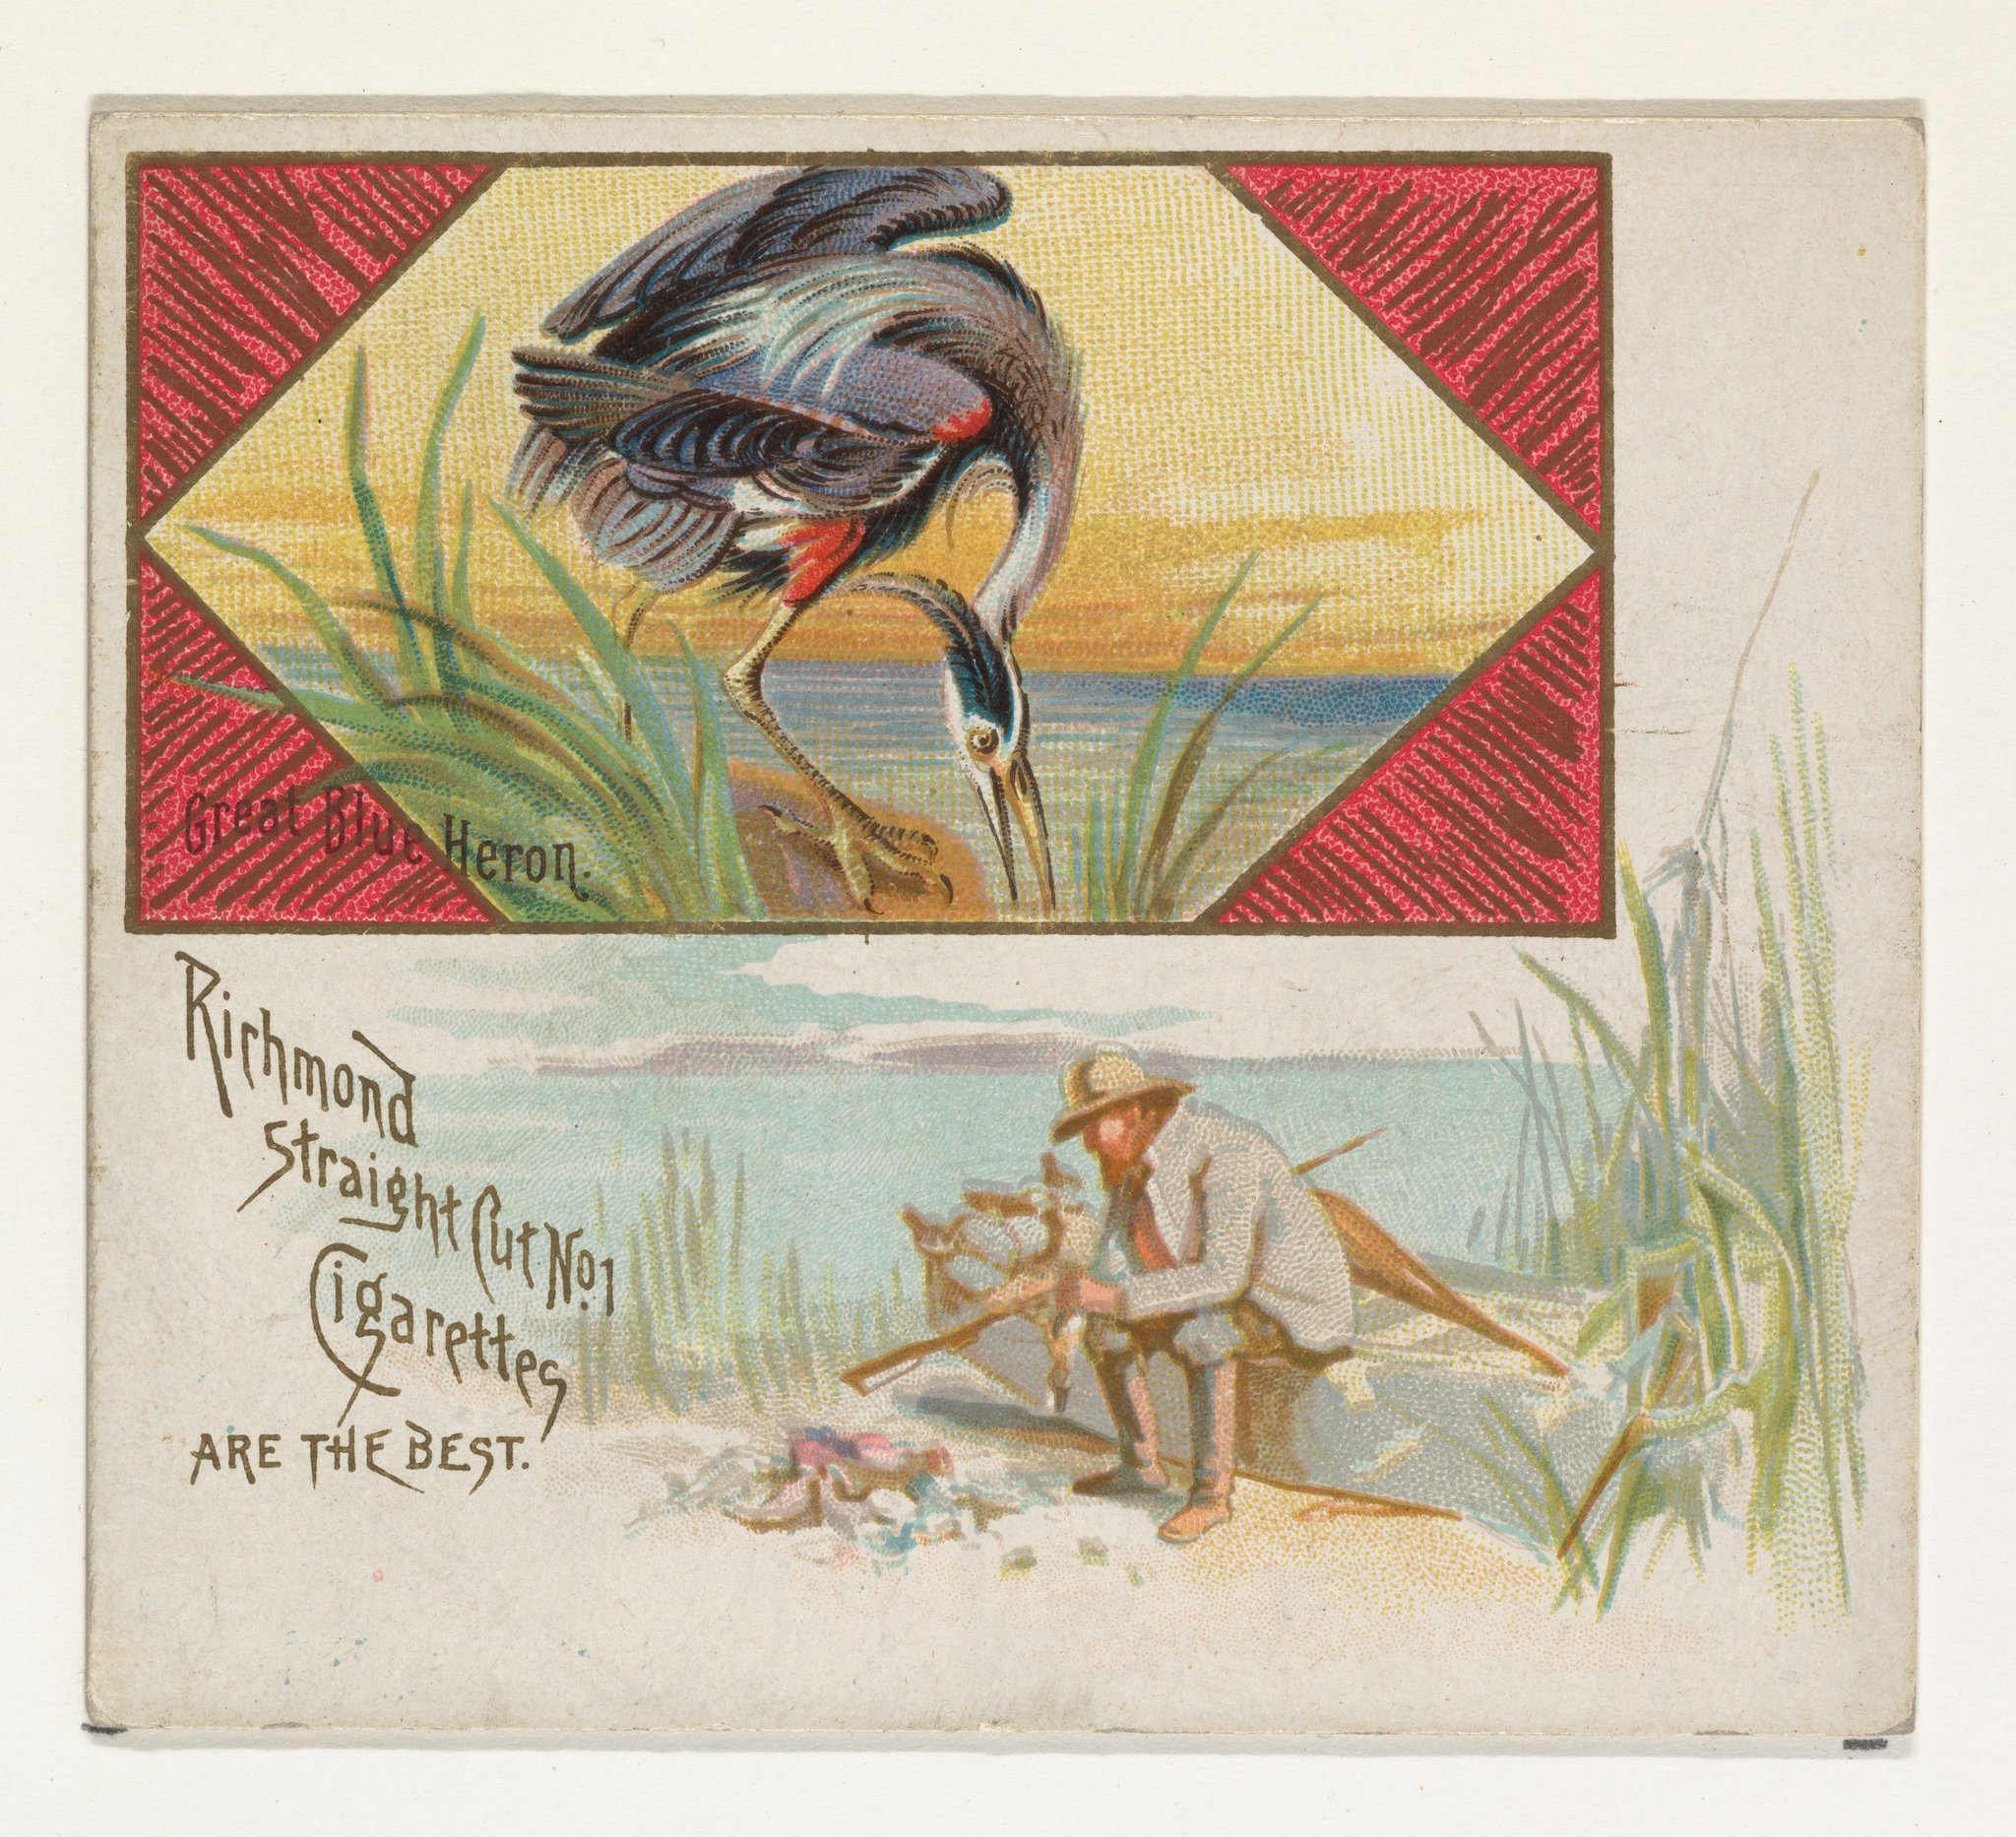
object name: print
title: Great Blue Heron, from the Game Birds series (N40) for Allen & Ginter Cigarettes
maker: allen & ginter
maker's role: publisher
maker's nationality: american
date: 1888-1890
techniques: color lithograph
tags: birds